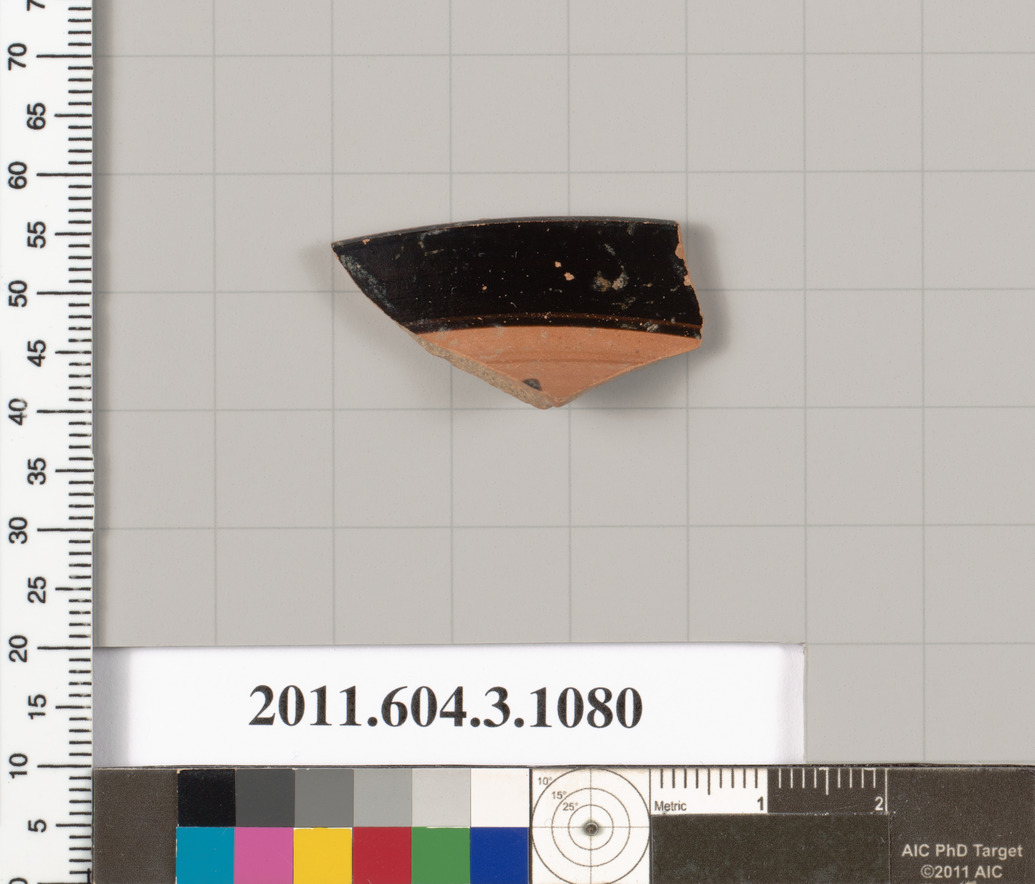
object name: mastoid fragment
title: Terracotta rim fragment of a mastoid (drinking cup with narrow base)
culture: greek, attic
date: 534-468 BCE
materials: terracotta